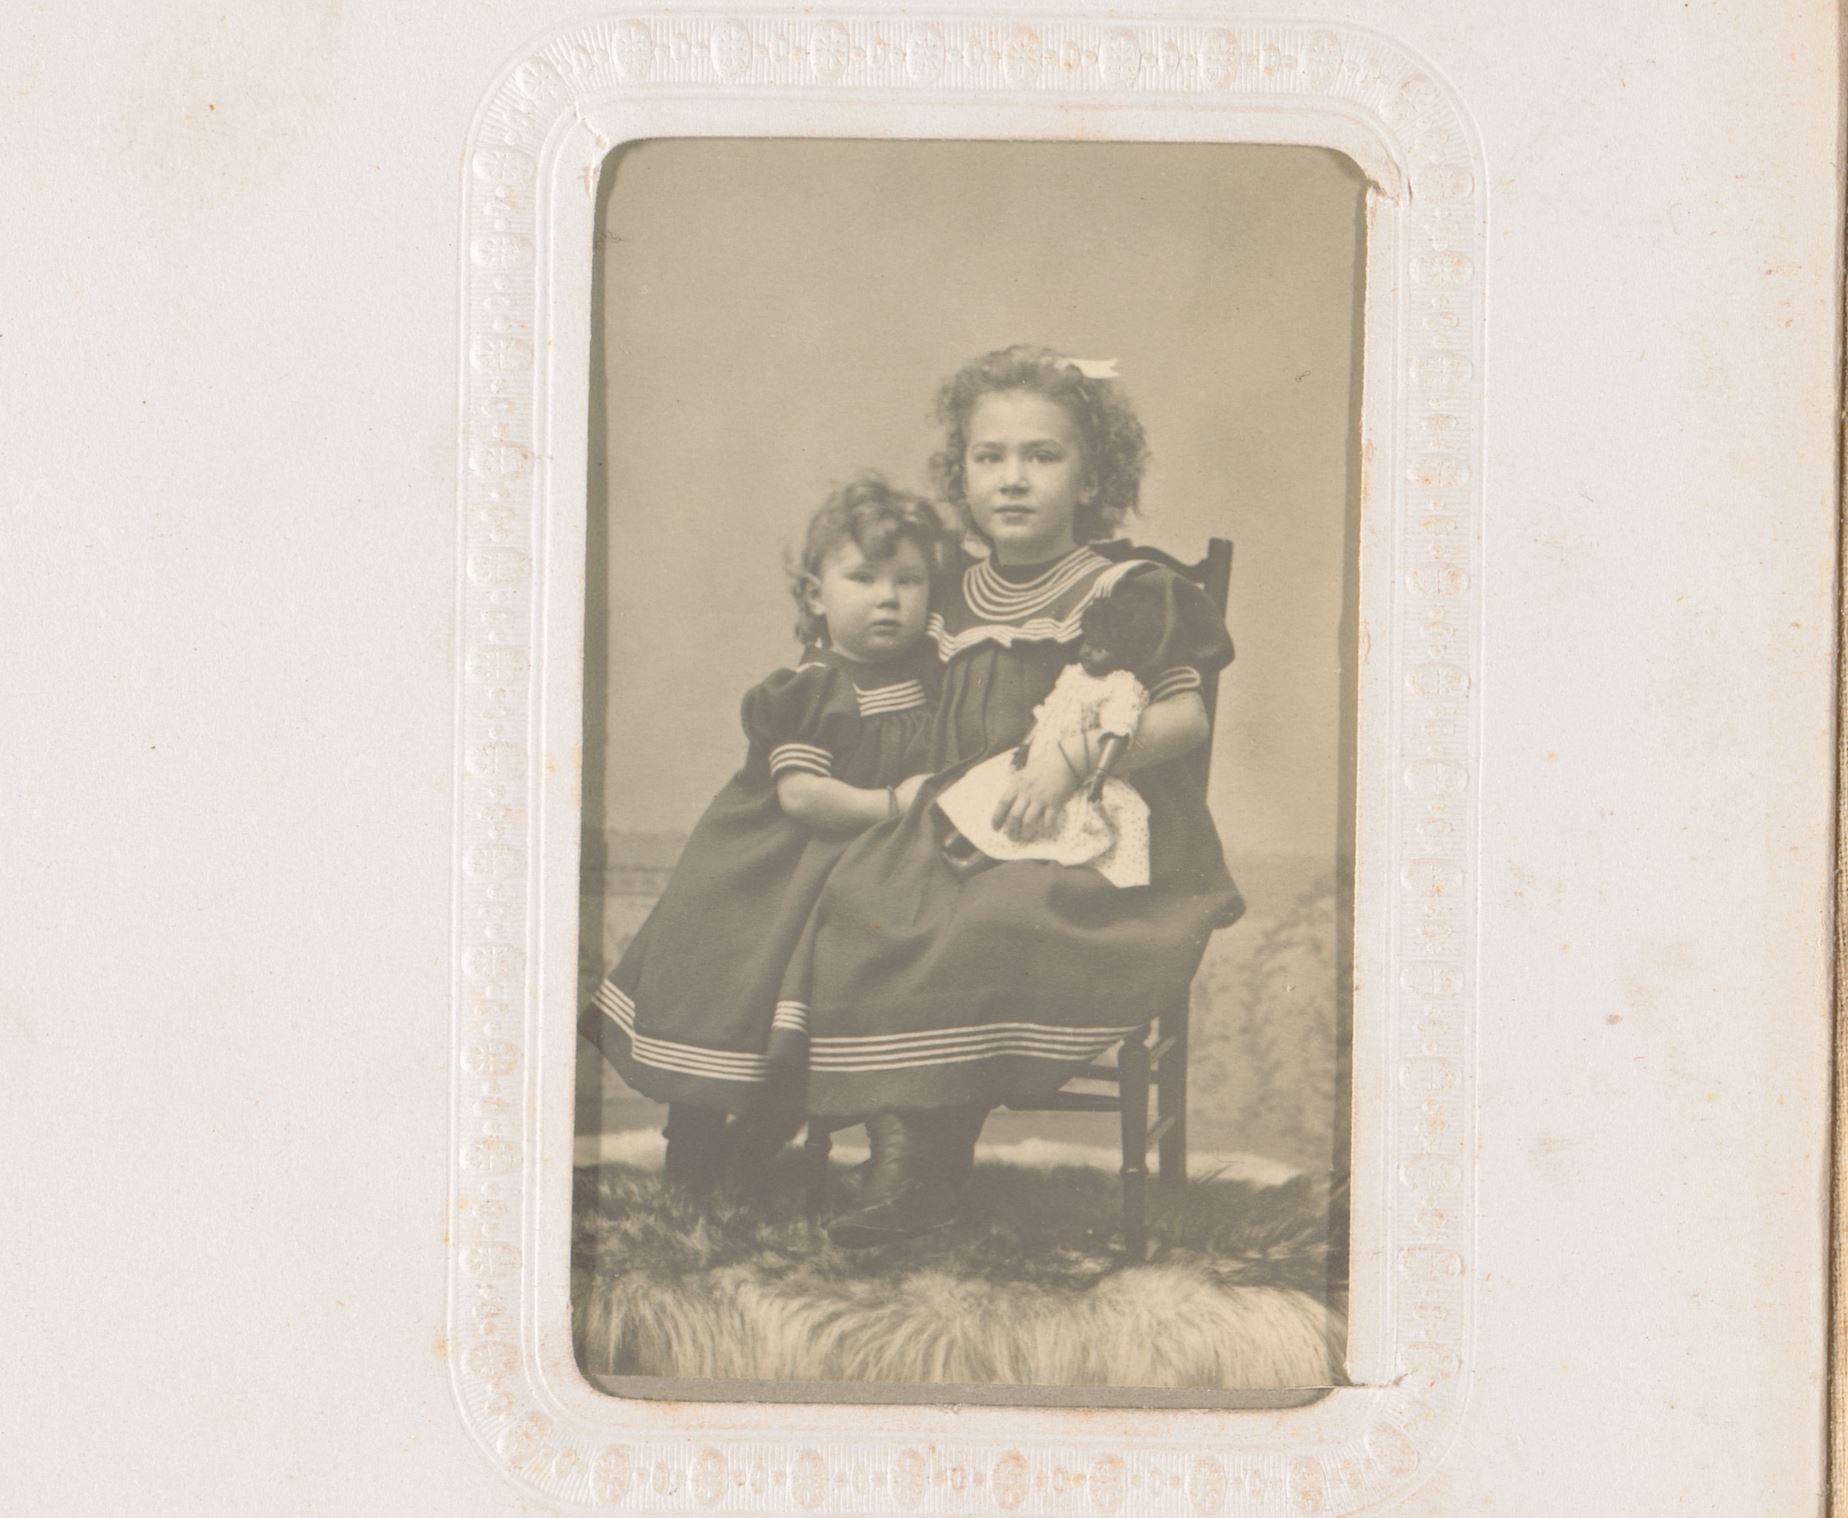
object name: carte de visite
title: Portret van twee meisjes, waarvan één zittend op een stoel met pop in de hand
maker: henriette l. kooy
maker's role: fotograaf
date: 1900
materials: cardboard, photographic support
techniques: collodion silver print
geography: hilversum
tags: historical persons - bb - woman, toddler (female) (+ two persons), (playing with) dolls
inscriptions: inscription: ‘Henriette L. Kooy/ Hilversum/ Bergweg.’